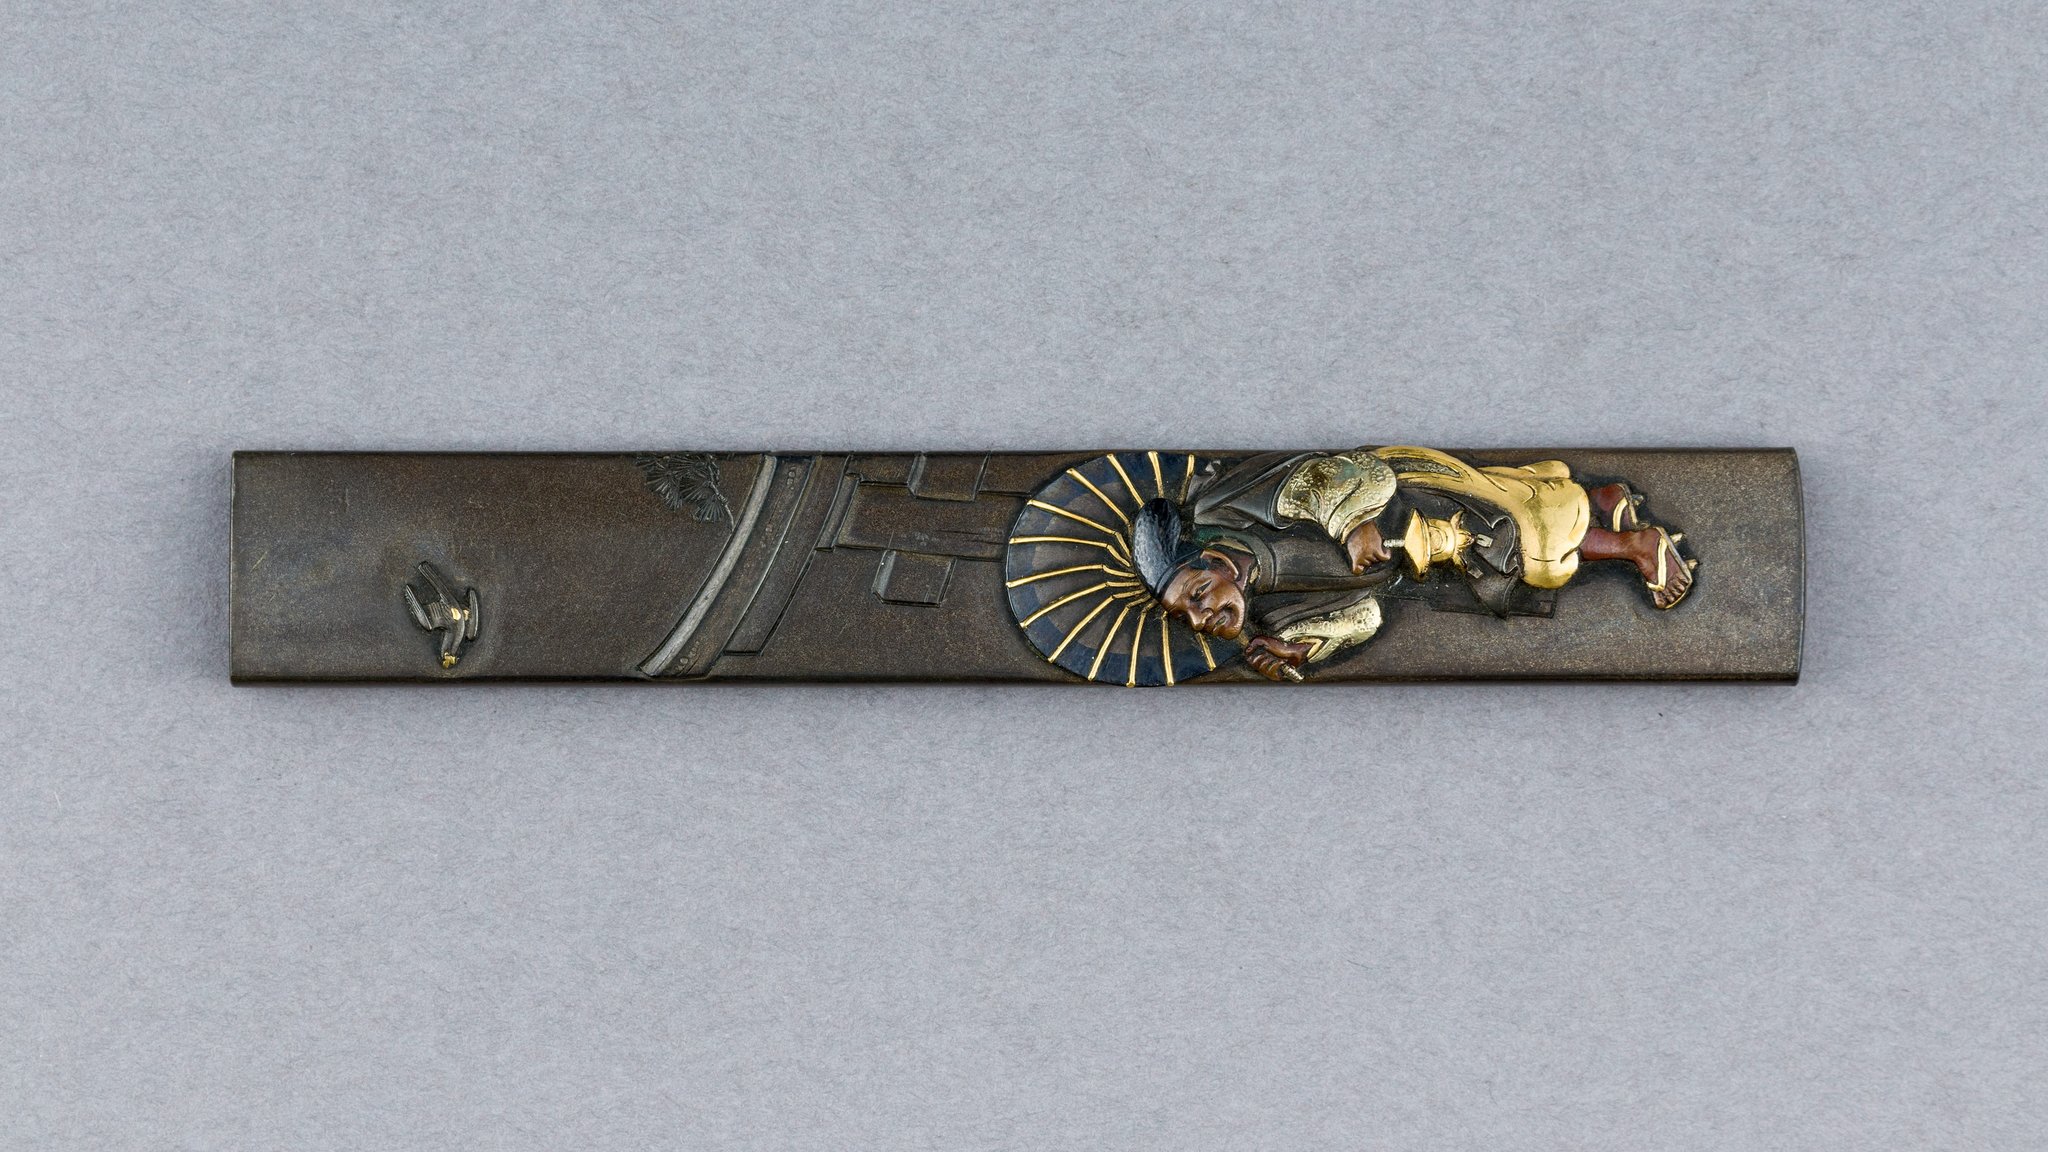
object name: knife handle kozuka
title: Knife Handle (Kozuka)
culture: japanese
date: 1615-1868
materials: copper, gold alloy, silver alloy, gold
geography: japan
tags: men